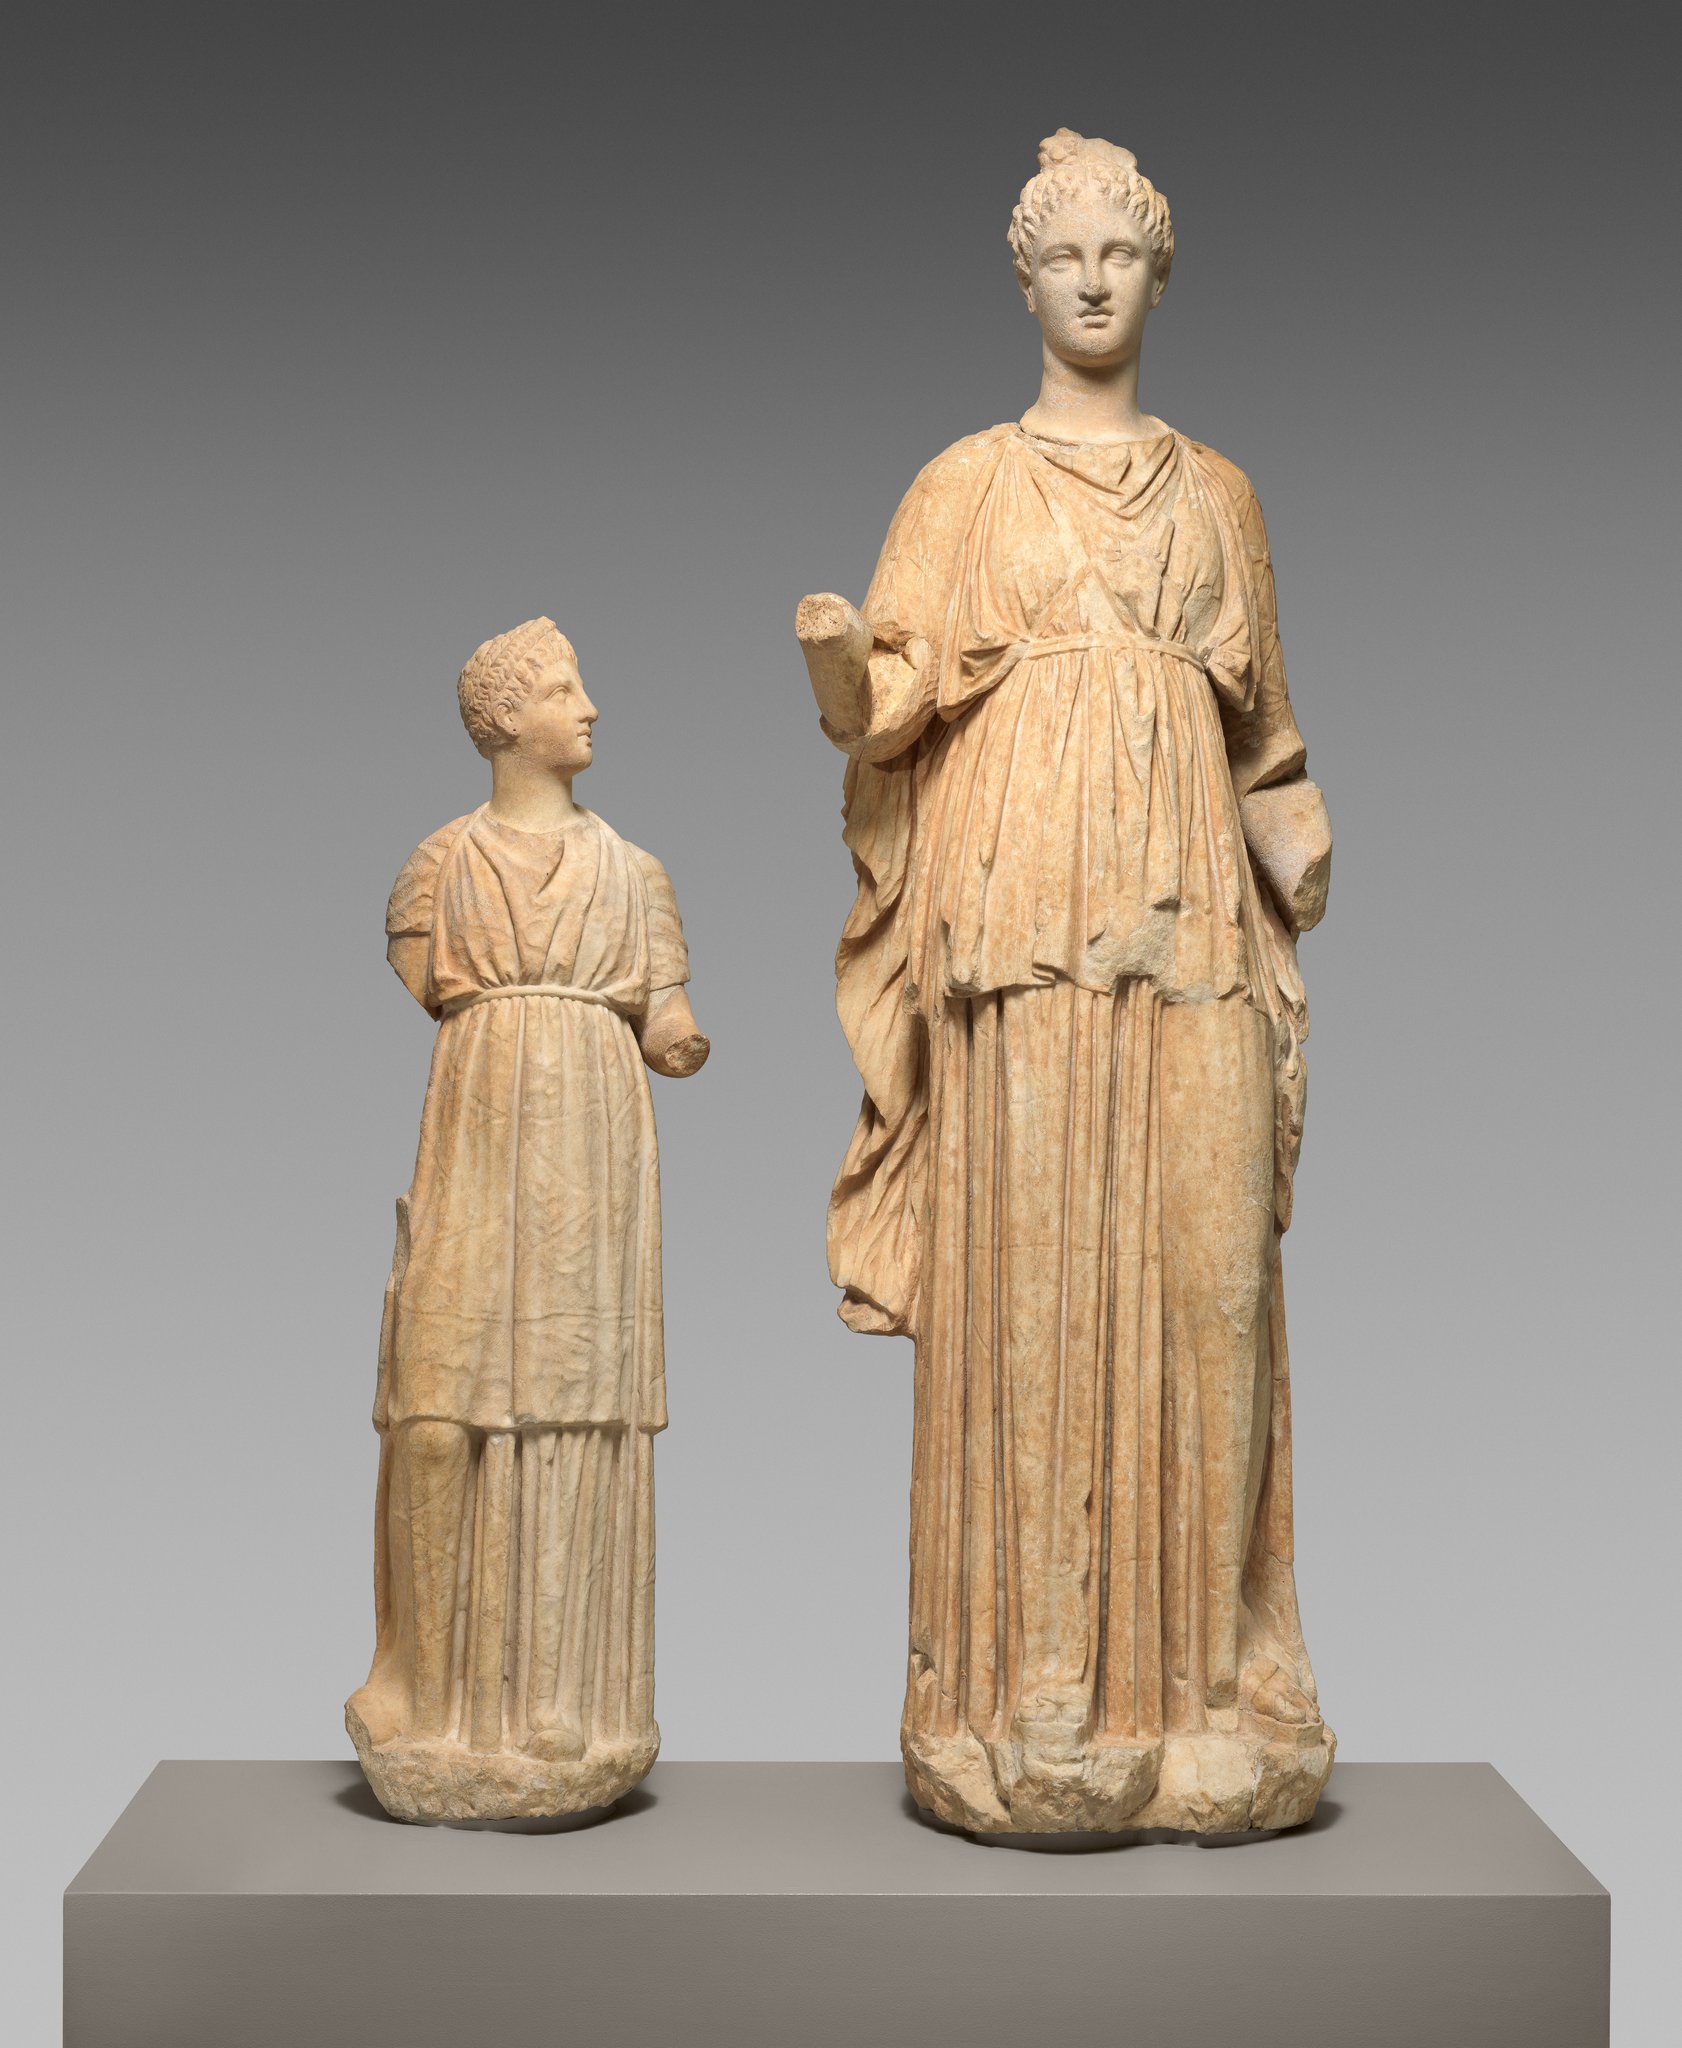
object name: statue of a maiden and a little girl, funerary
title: Marble funerary statues of a maiden and a little girl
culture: greek, attic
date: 320 BCE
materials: marble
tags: girls,women